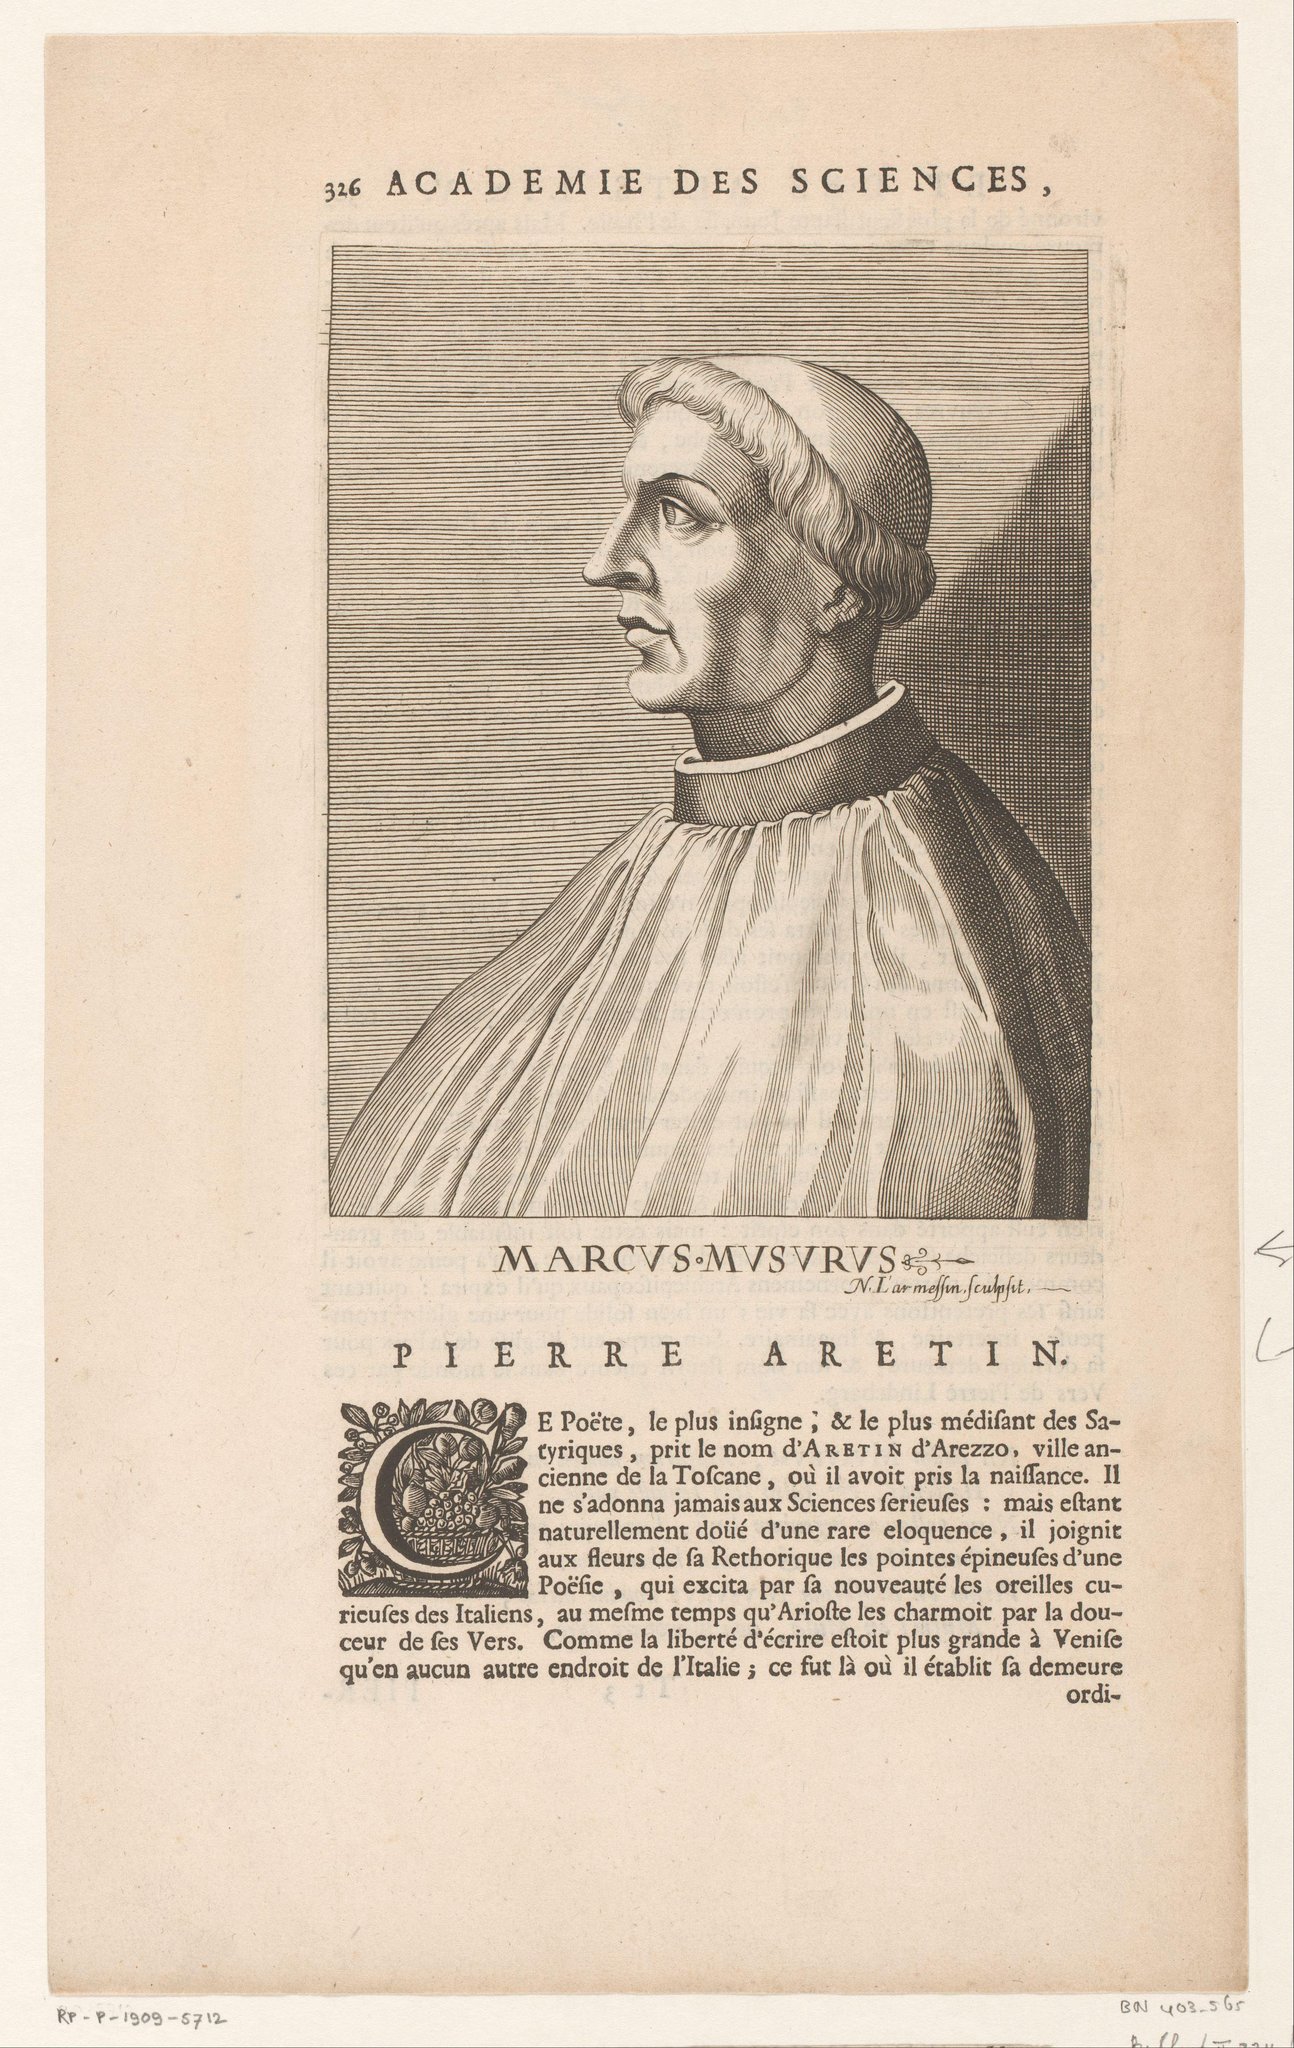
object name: print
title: Jean de Barnevelt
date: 1682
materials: paper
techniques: engraving, letterpress printing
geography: brussels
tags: johan van oldenbarnevelt, historical persons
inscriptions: collector's mark: Lugt 2228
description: Prent gebruikt voor: Bullart, Isaac. Académie des Sciences et Arts contenant les vies et éloges his. des hommes illustres qui ont excellé en ces professions depuis environ quatre siècles. Brussel: François Foppens, 1682. Het boek werd in 1682 eveneens in Amsterdam uitgegeven door de erfgenamen van Daniel Elzevier. Ieder portret betreft een illustratie bij de biografie van een kunstenaar of geleerde. De meeste portretten werden door Nicolas de Larmessin vervaardigd (162), 93 door De Boulonois en een derde door ongeïdentificeerde prentmakers. Dit betreft een illustratie op p. 99, deel I.